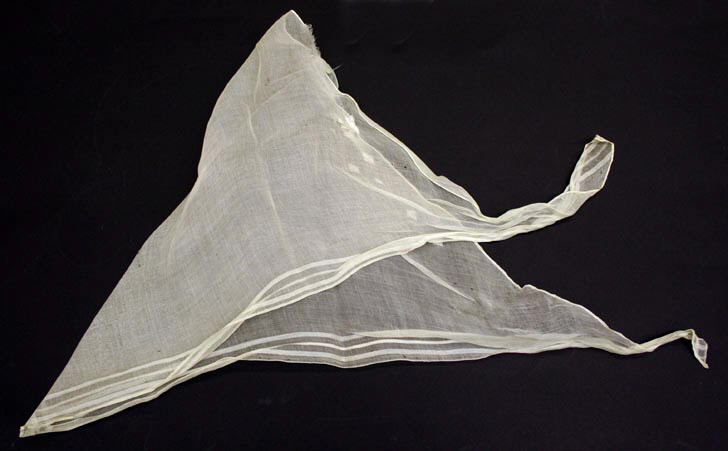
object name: kerchief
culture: american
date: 1700-1942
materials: cotton